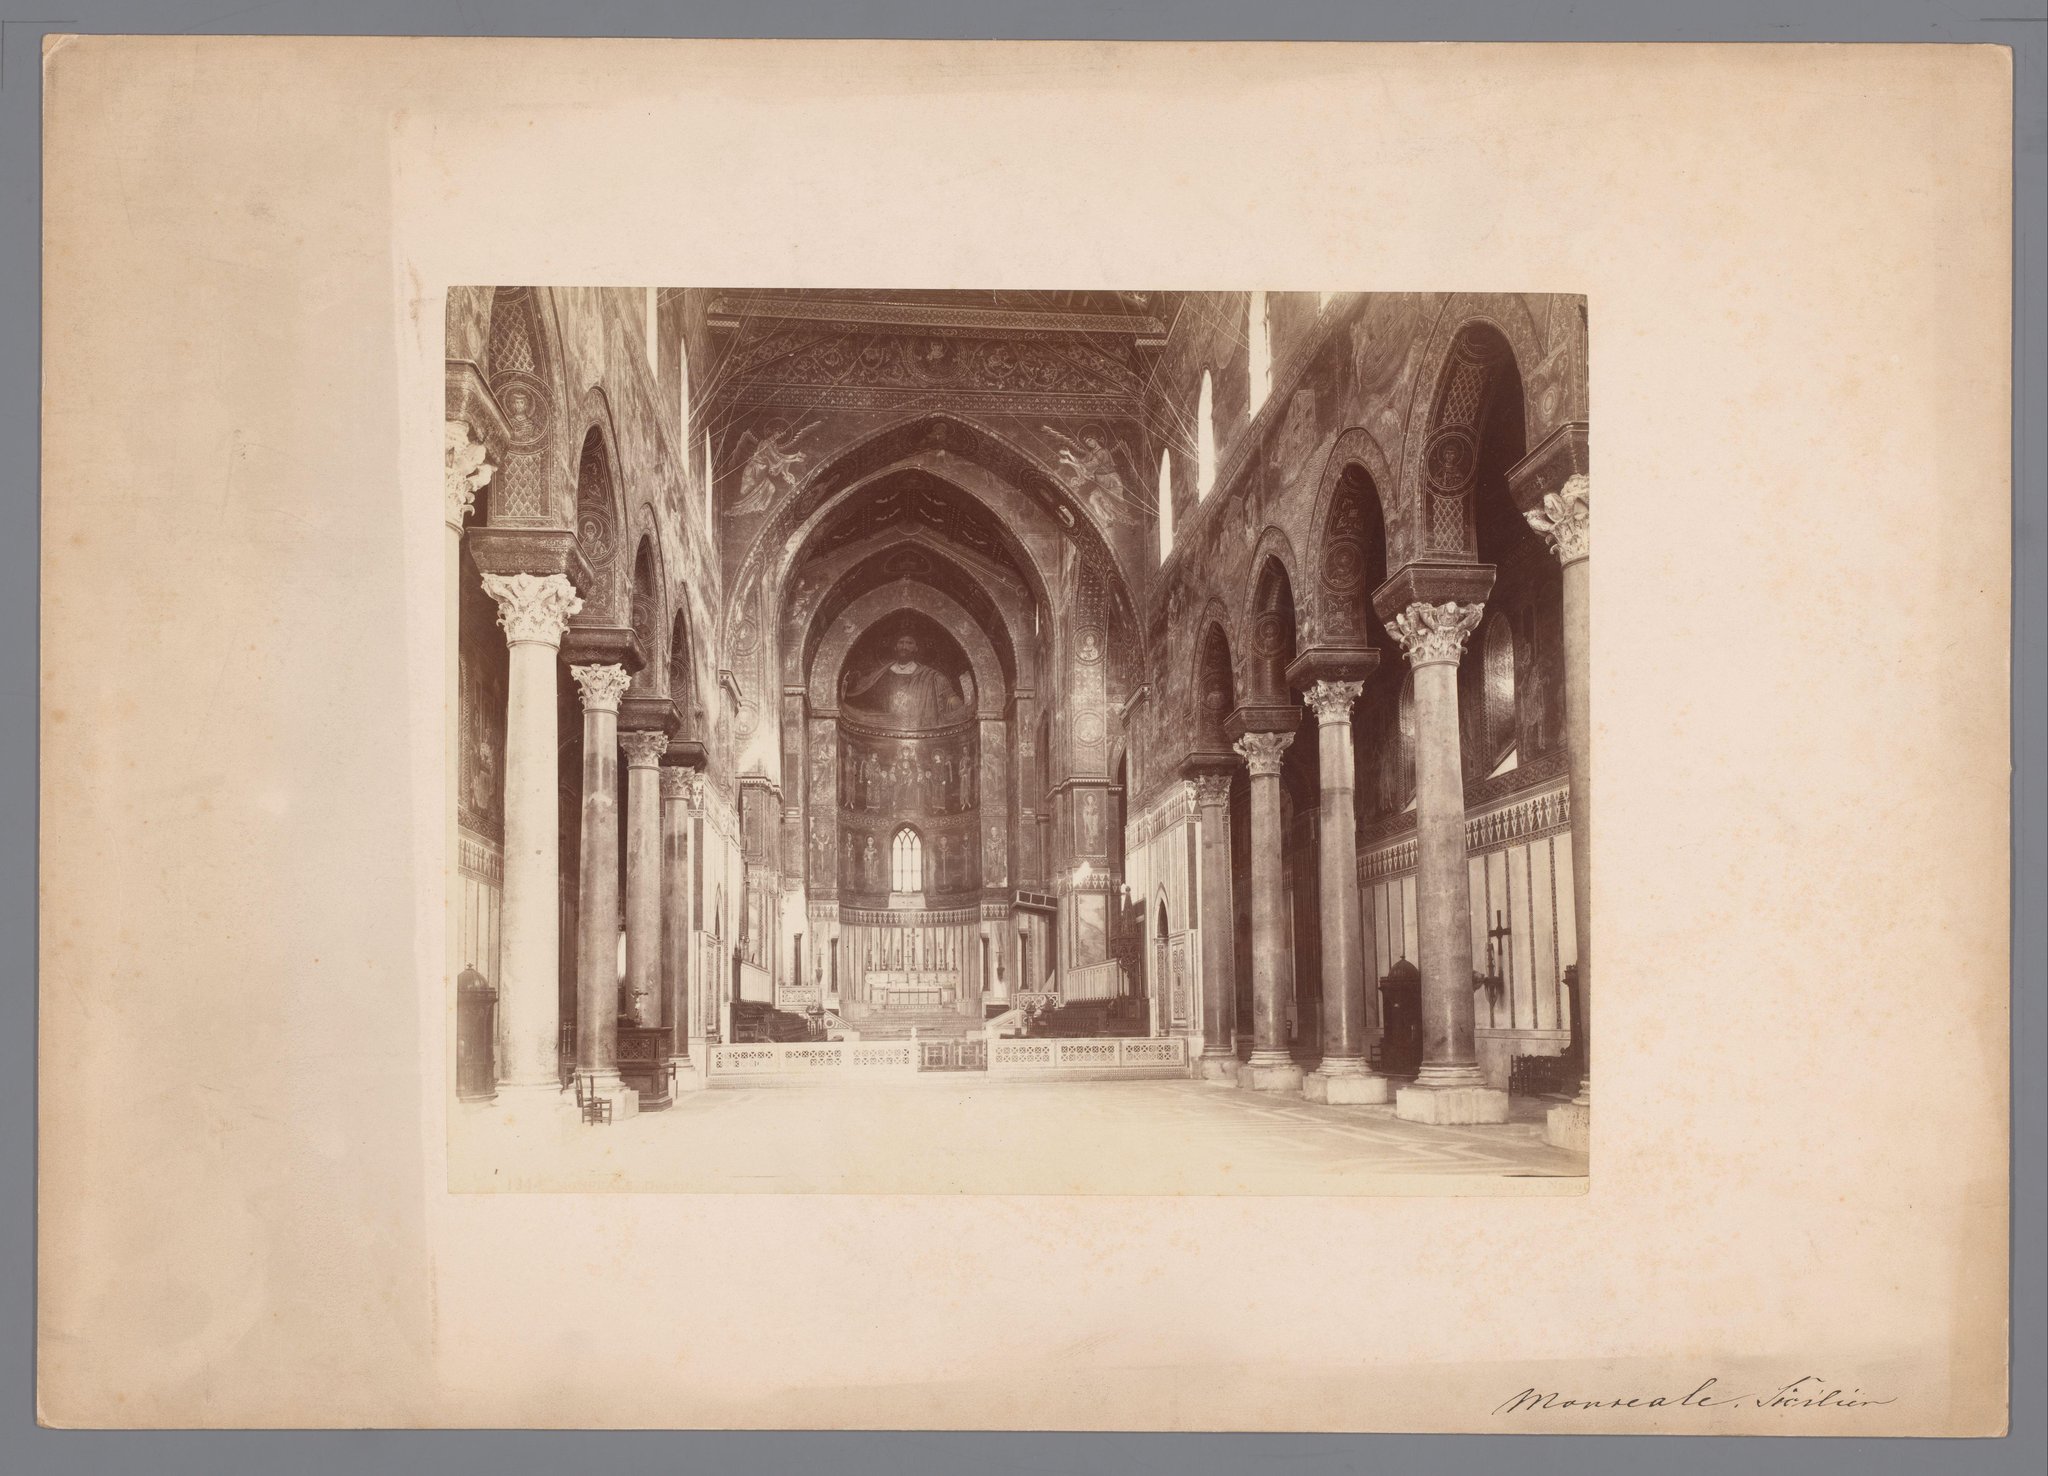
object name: photograph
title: Monreale Sicilië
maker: giorgio sommer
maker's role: fotograaf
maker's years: 1834-1914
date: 1857-1914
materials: cardboard, paper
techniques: albumen print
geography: monreale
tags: interior of church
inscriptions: inscription: ‘'19.173’, stamp: ‘R: MVS.’, number: ‘134’